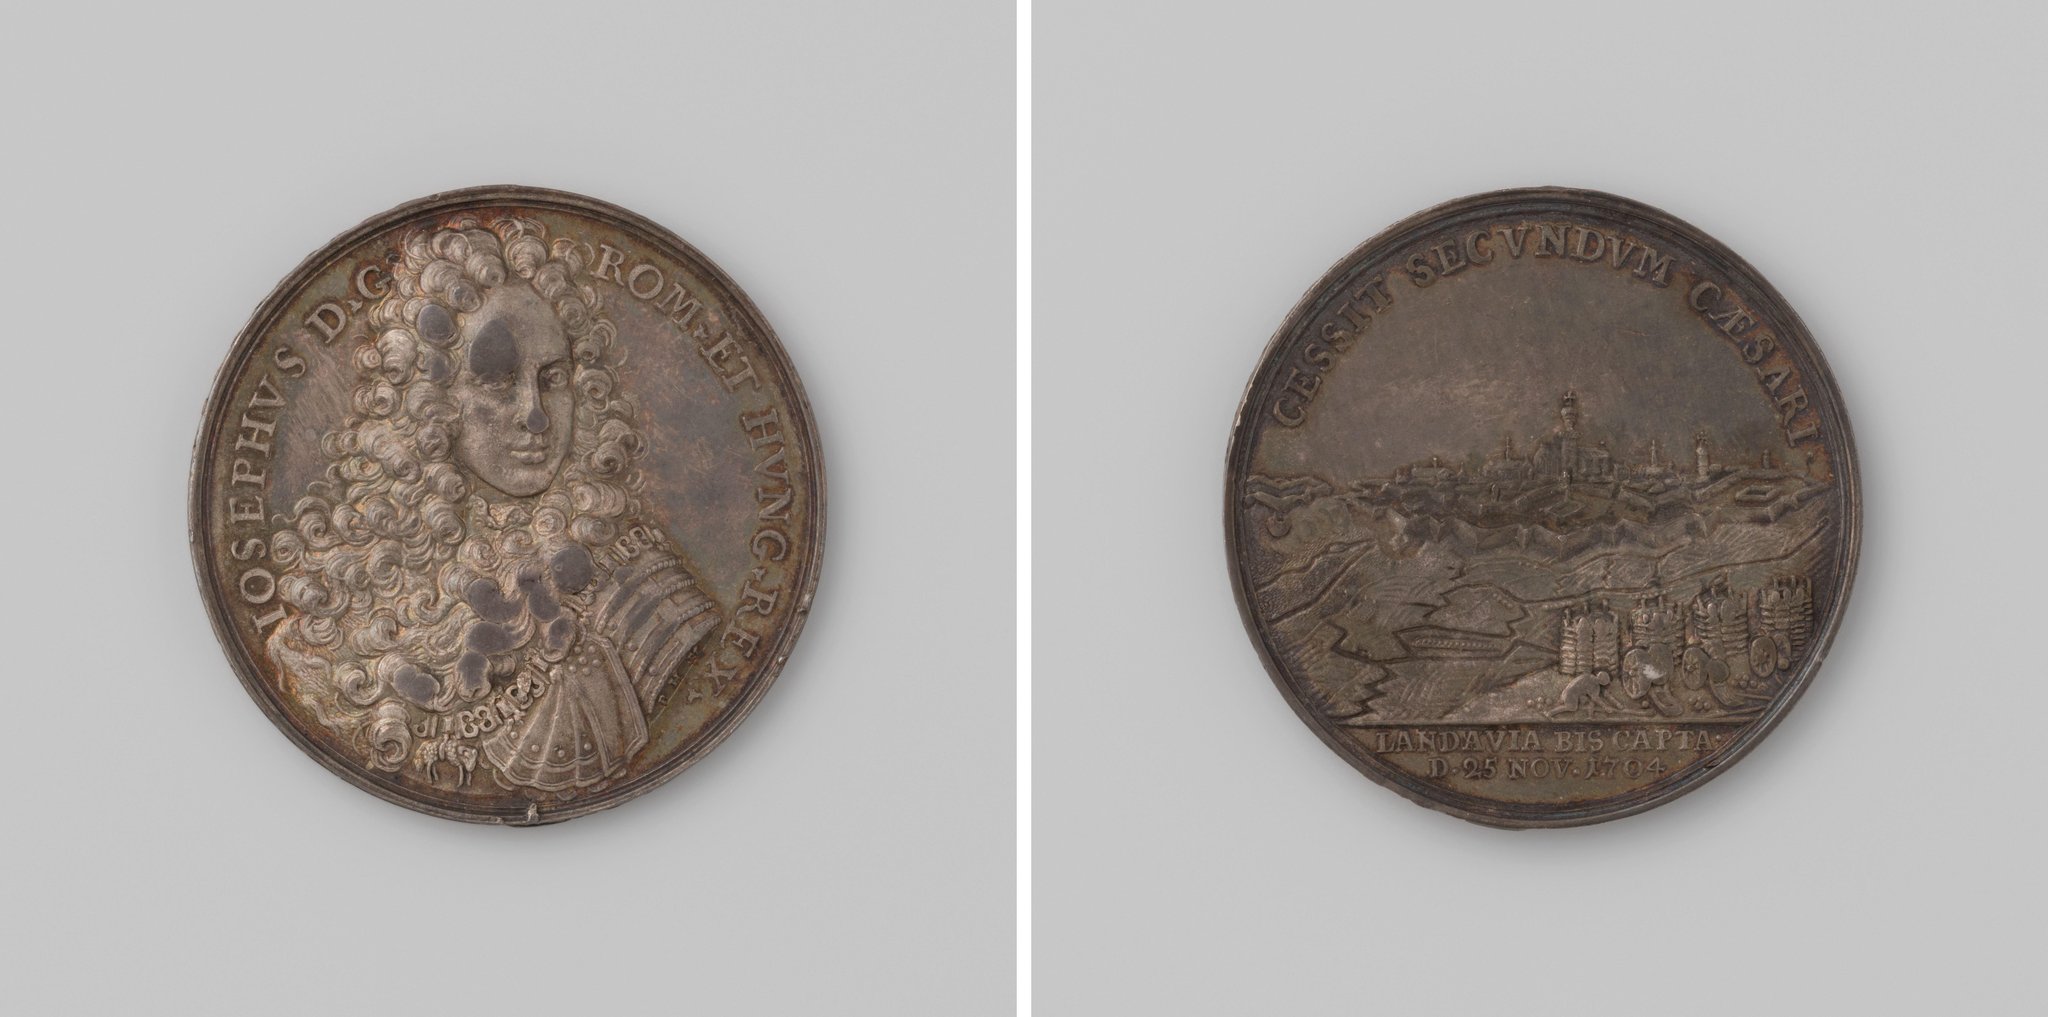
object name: history medal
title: Landau opnieuw door Jozef I ingenomen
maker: philipp heinrich müller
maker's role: medailleur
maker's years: 1654-1719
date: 1704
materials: silver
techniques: striking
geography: nuremberg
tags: vienna, jozef i (duits keizer)